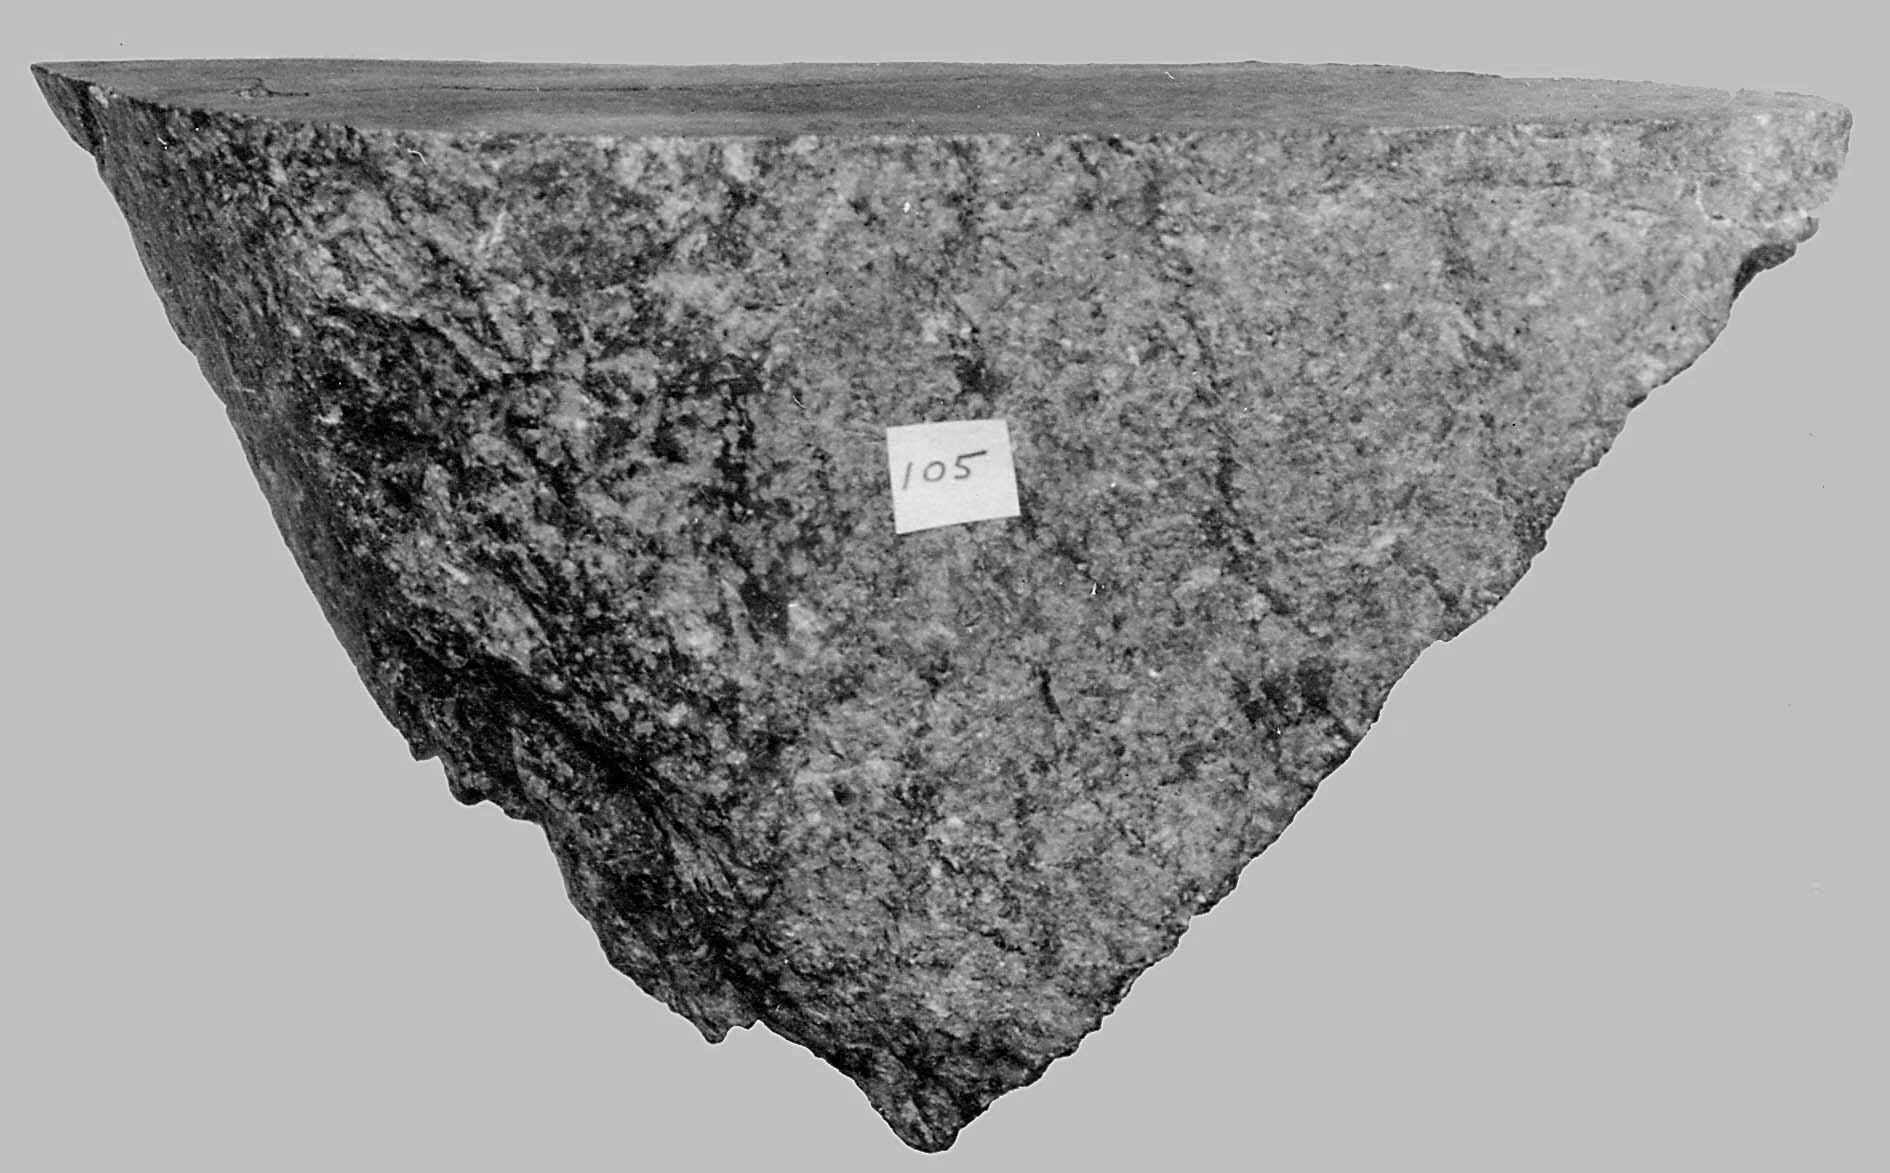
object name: fragment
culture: russian, siberia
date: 1902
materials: jade